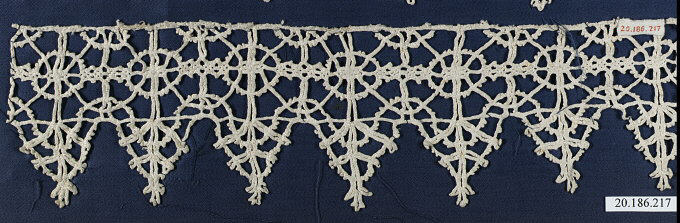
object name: edging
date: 1601-1700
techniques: lace